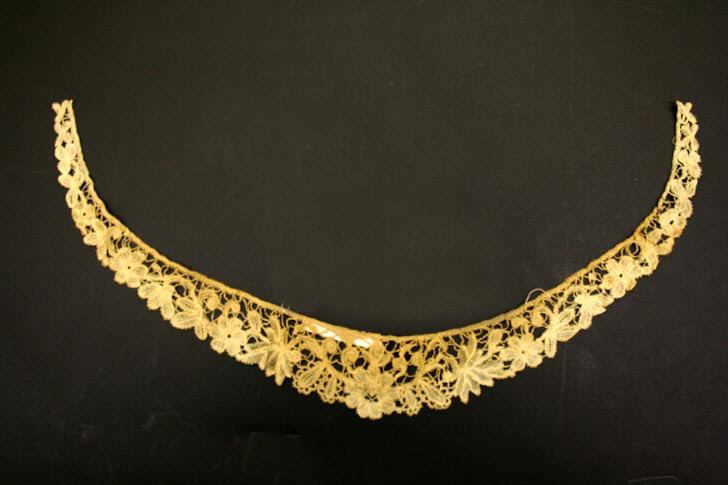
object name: collar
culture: american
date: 1700-1939